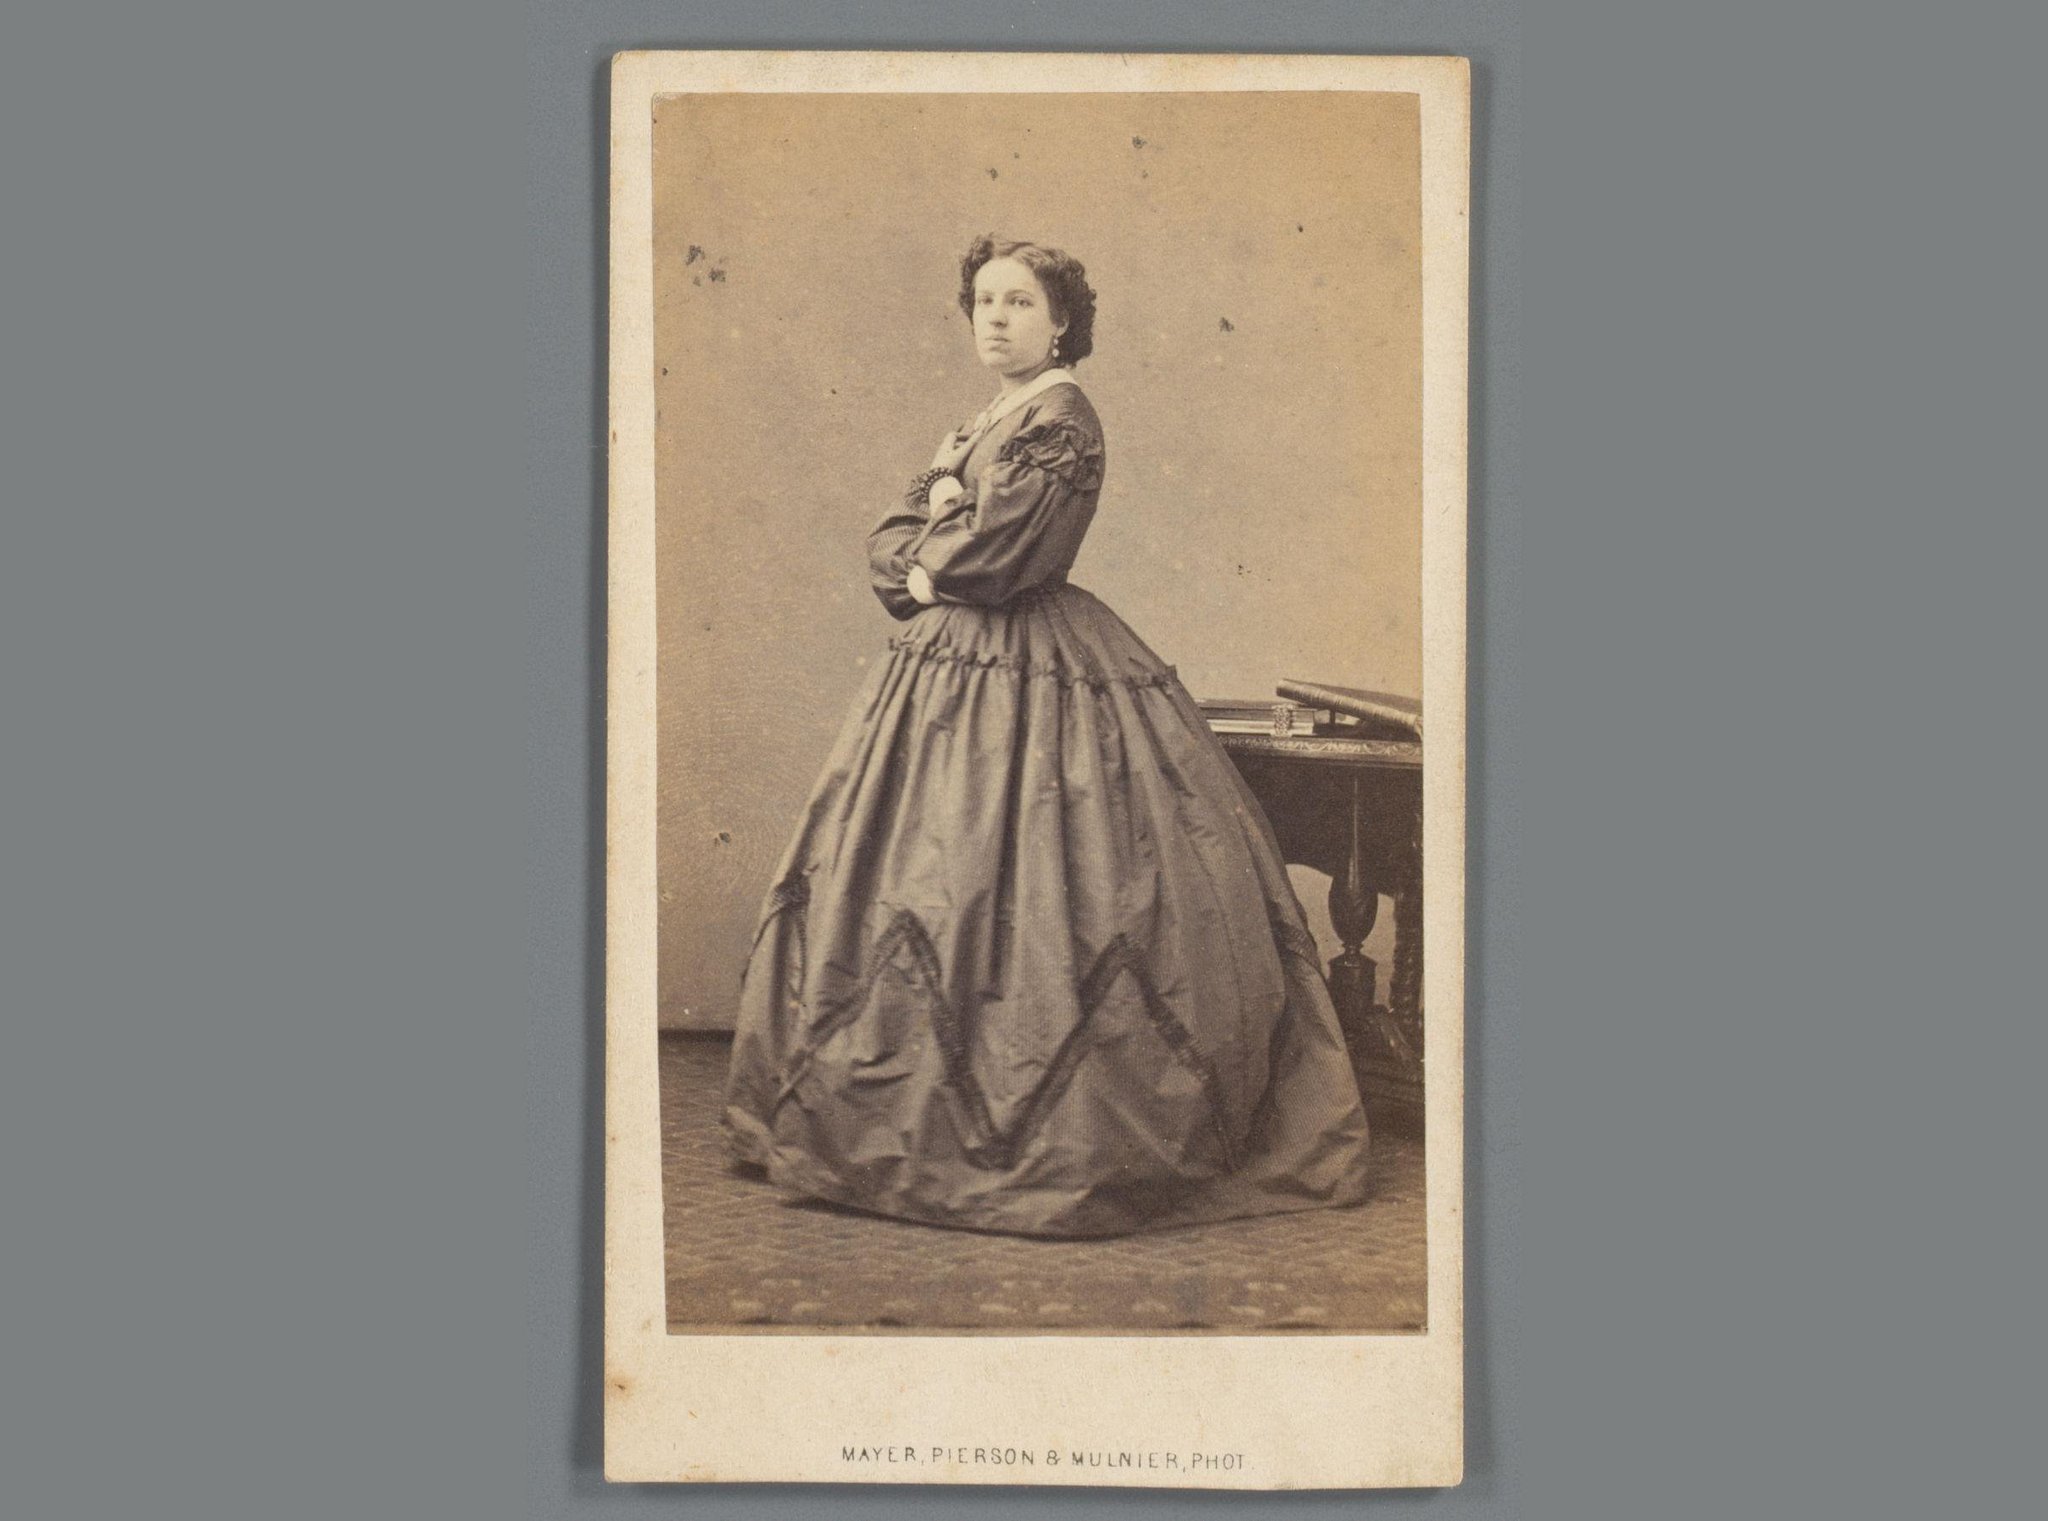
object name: carte de visite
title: Portret van een onbekende vrouw uit de familie en de kring van Eugene van Delden en Belle van Delden-Denninghof Stelling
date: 1855-1866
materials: cardboard, paper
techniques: albumen print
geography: brussels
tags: historical persons not known by name - bb - woman, dress, gown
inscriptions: inscription: ‘Mayer, Pierson & Mulnier/ Photographes de S.M. l'Empereur/ Rue des Fripiers 32/ Bruxelles.’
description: Portret uit de kring van Eugene van Delden (Hartapoera, 1865 - Den Haag, 1954) en Belle van Delden-Denninghof Stelling (Batavia, 1870 - Den Haag, 1947).